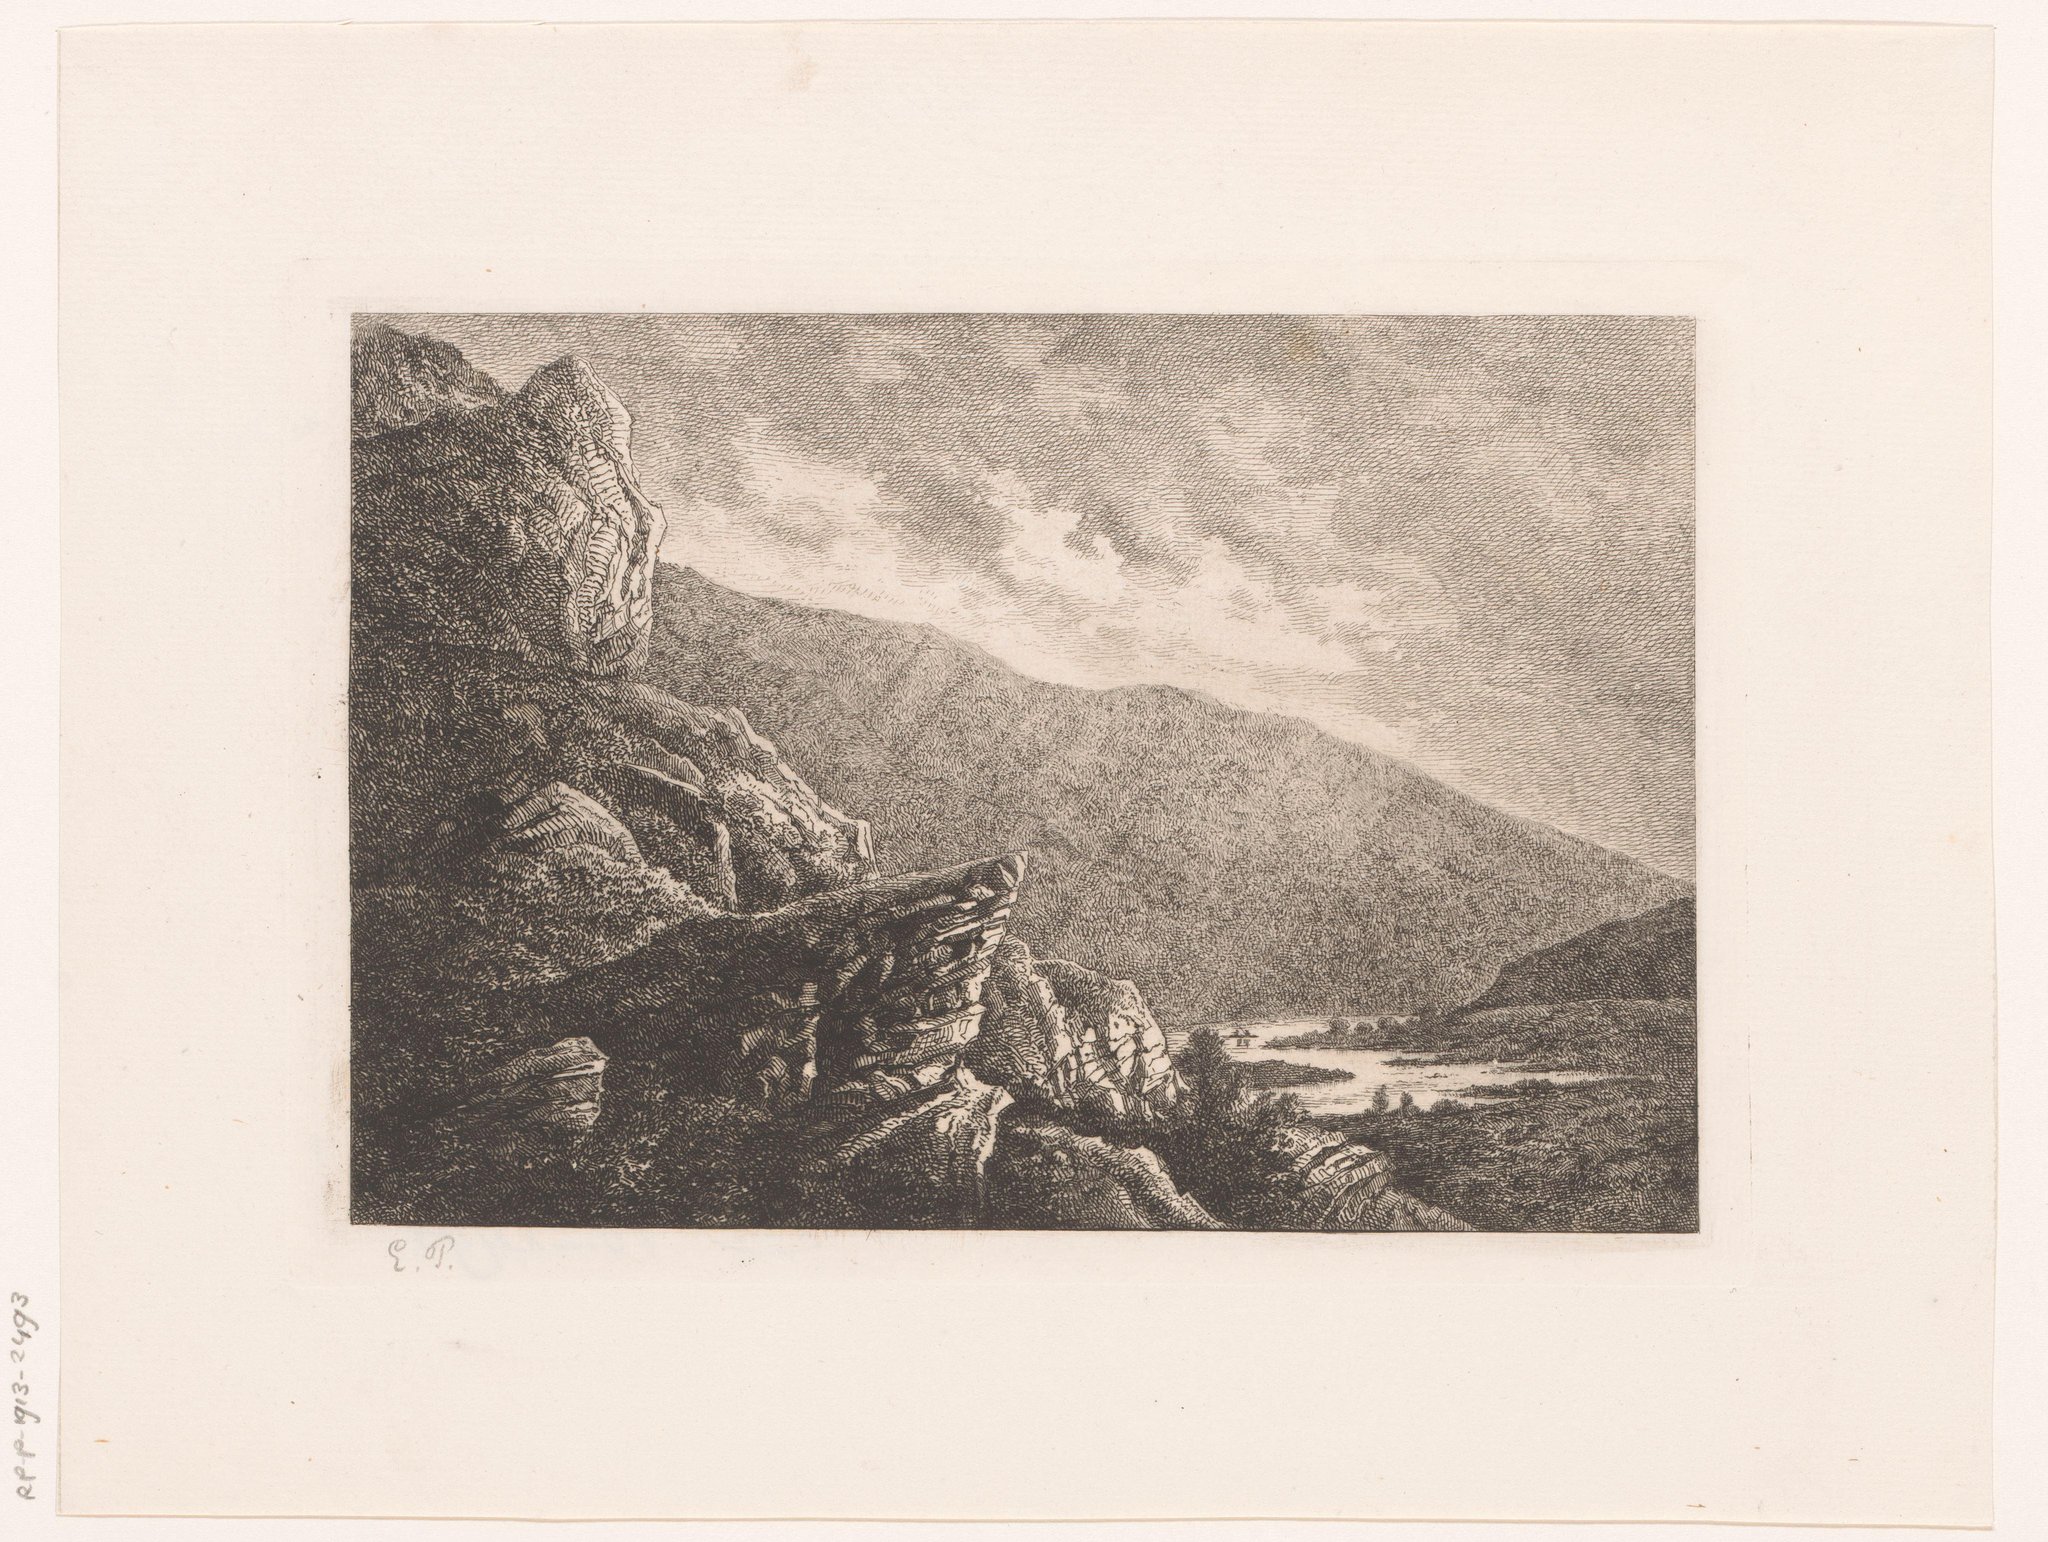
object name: print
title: Rotslandschap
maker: emile puttaert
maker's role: print maker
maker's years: 1829-1901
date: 1873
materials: paper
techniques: drypoint, etching, intaglio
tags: river (+ landscape with figures, staffage), mountains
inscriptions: collector's mark: Lugt 2228